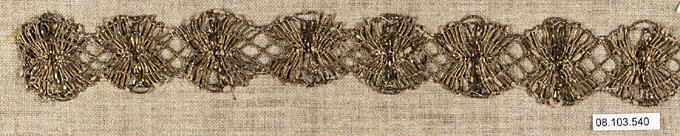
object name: piece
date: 1701-1900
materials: gold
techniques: lace